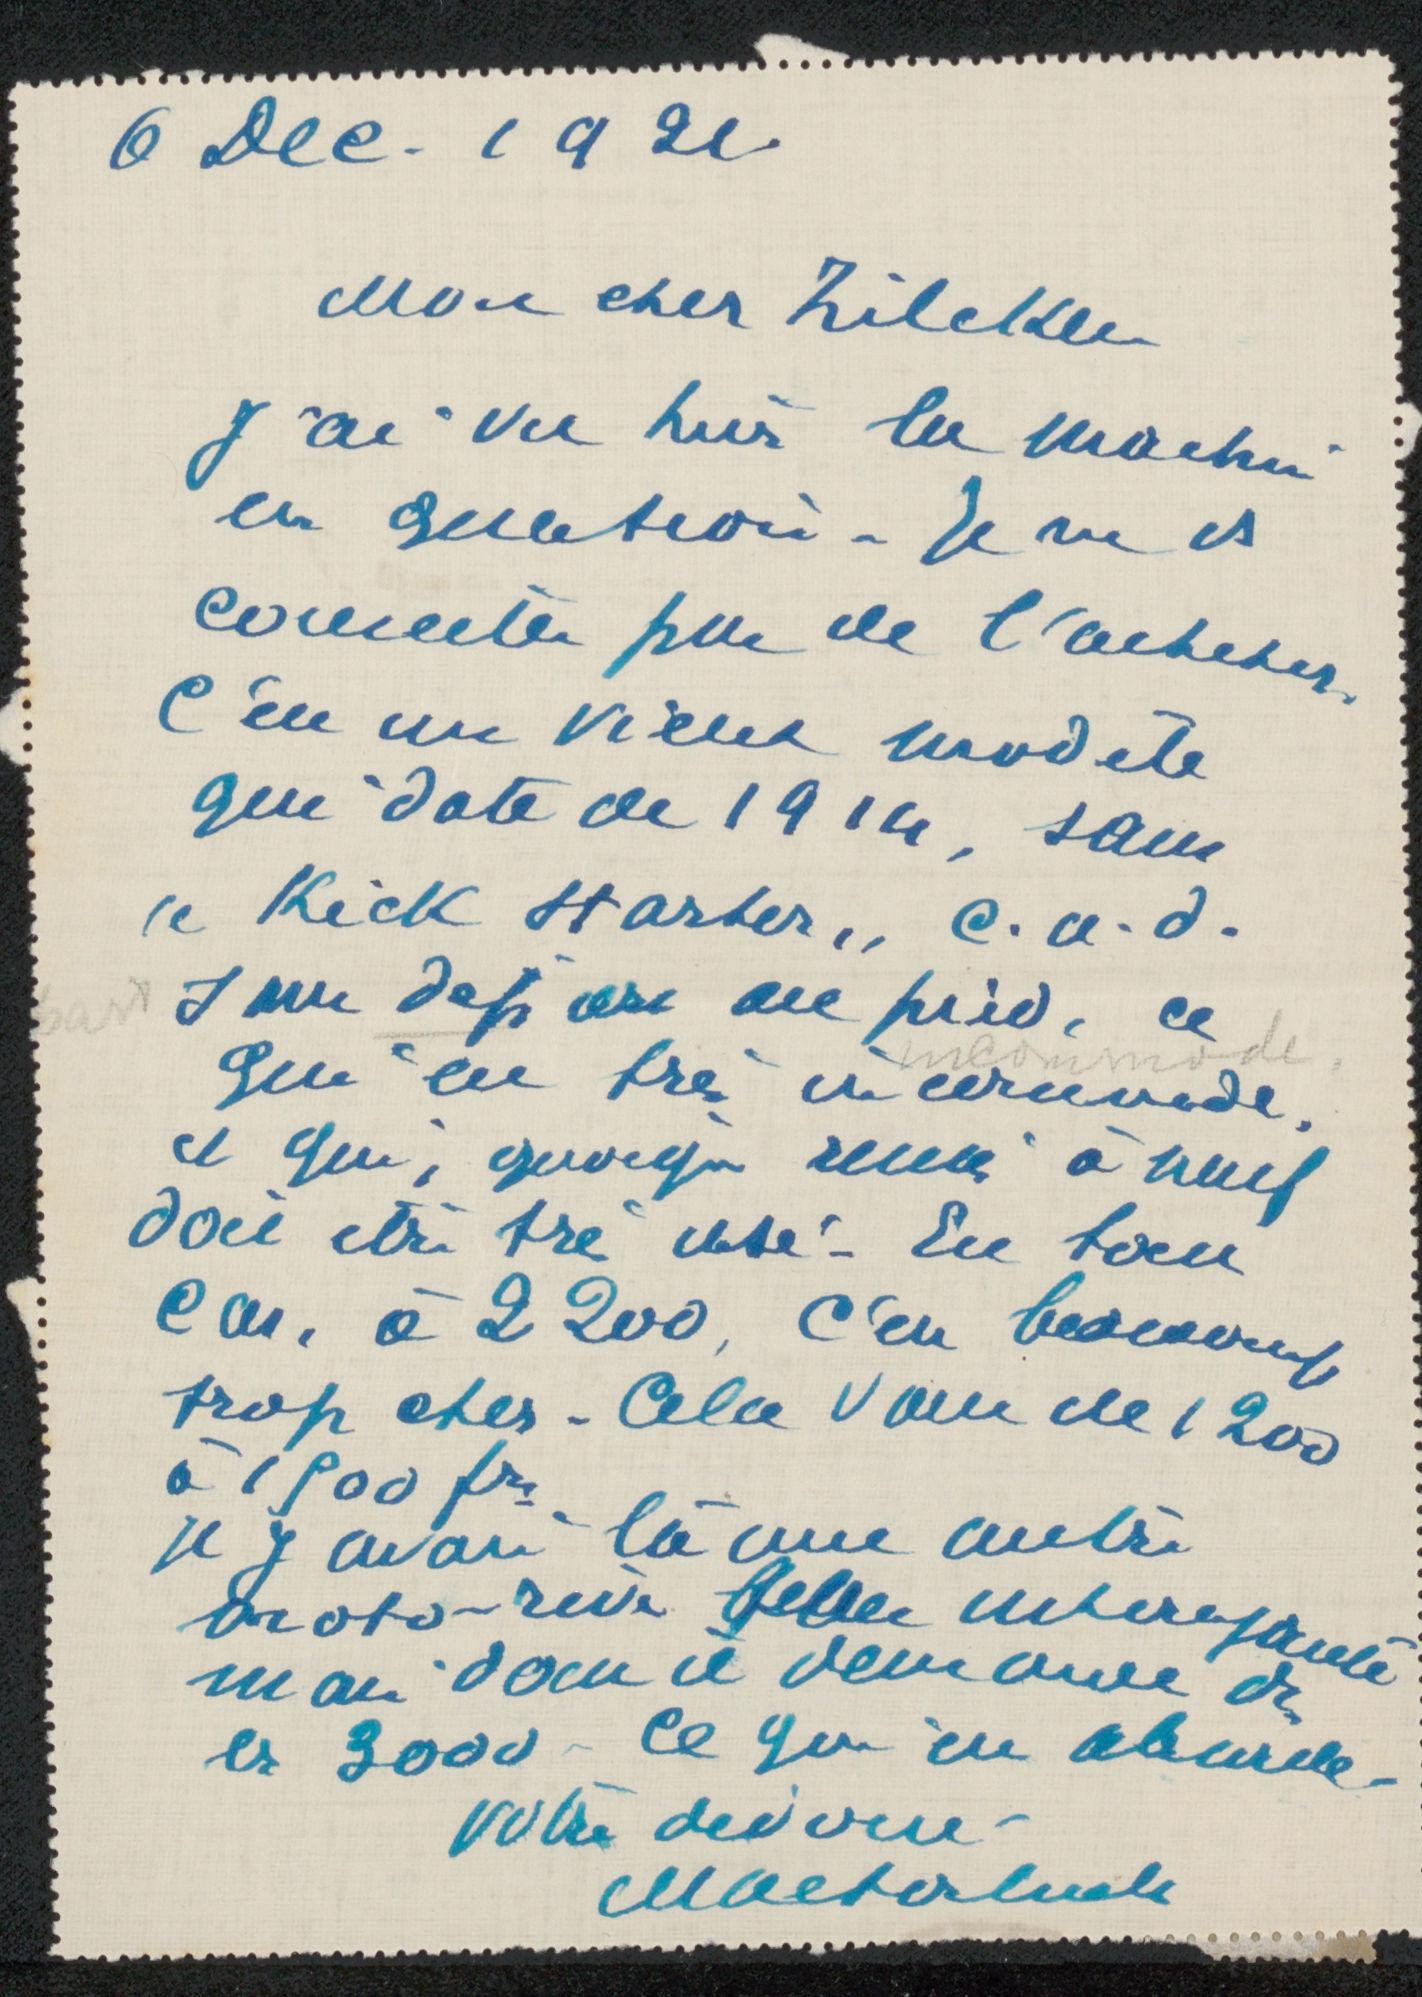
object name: letter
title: Brief aan Philip Zilcken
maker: maurice maeterlinck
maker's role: dichter, essayist, toneelschrijver, vertaler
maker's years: 1862-1949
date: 1921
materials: ink, paper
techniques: pen, writing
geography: nice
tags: the hague, painter, draughtsman, philip zilcken, money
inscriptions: collector's mark: ‘RPK’